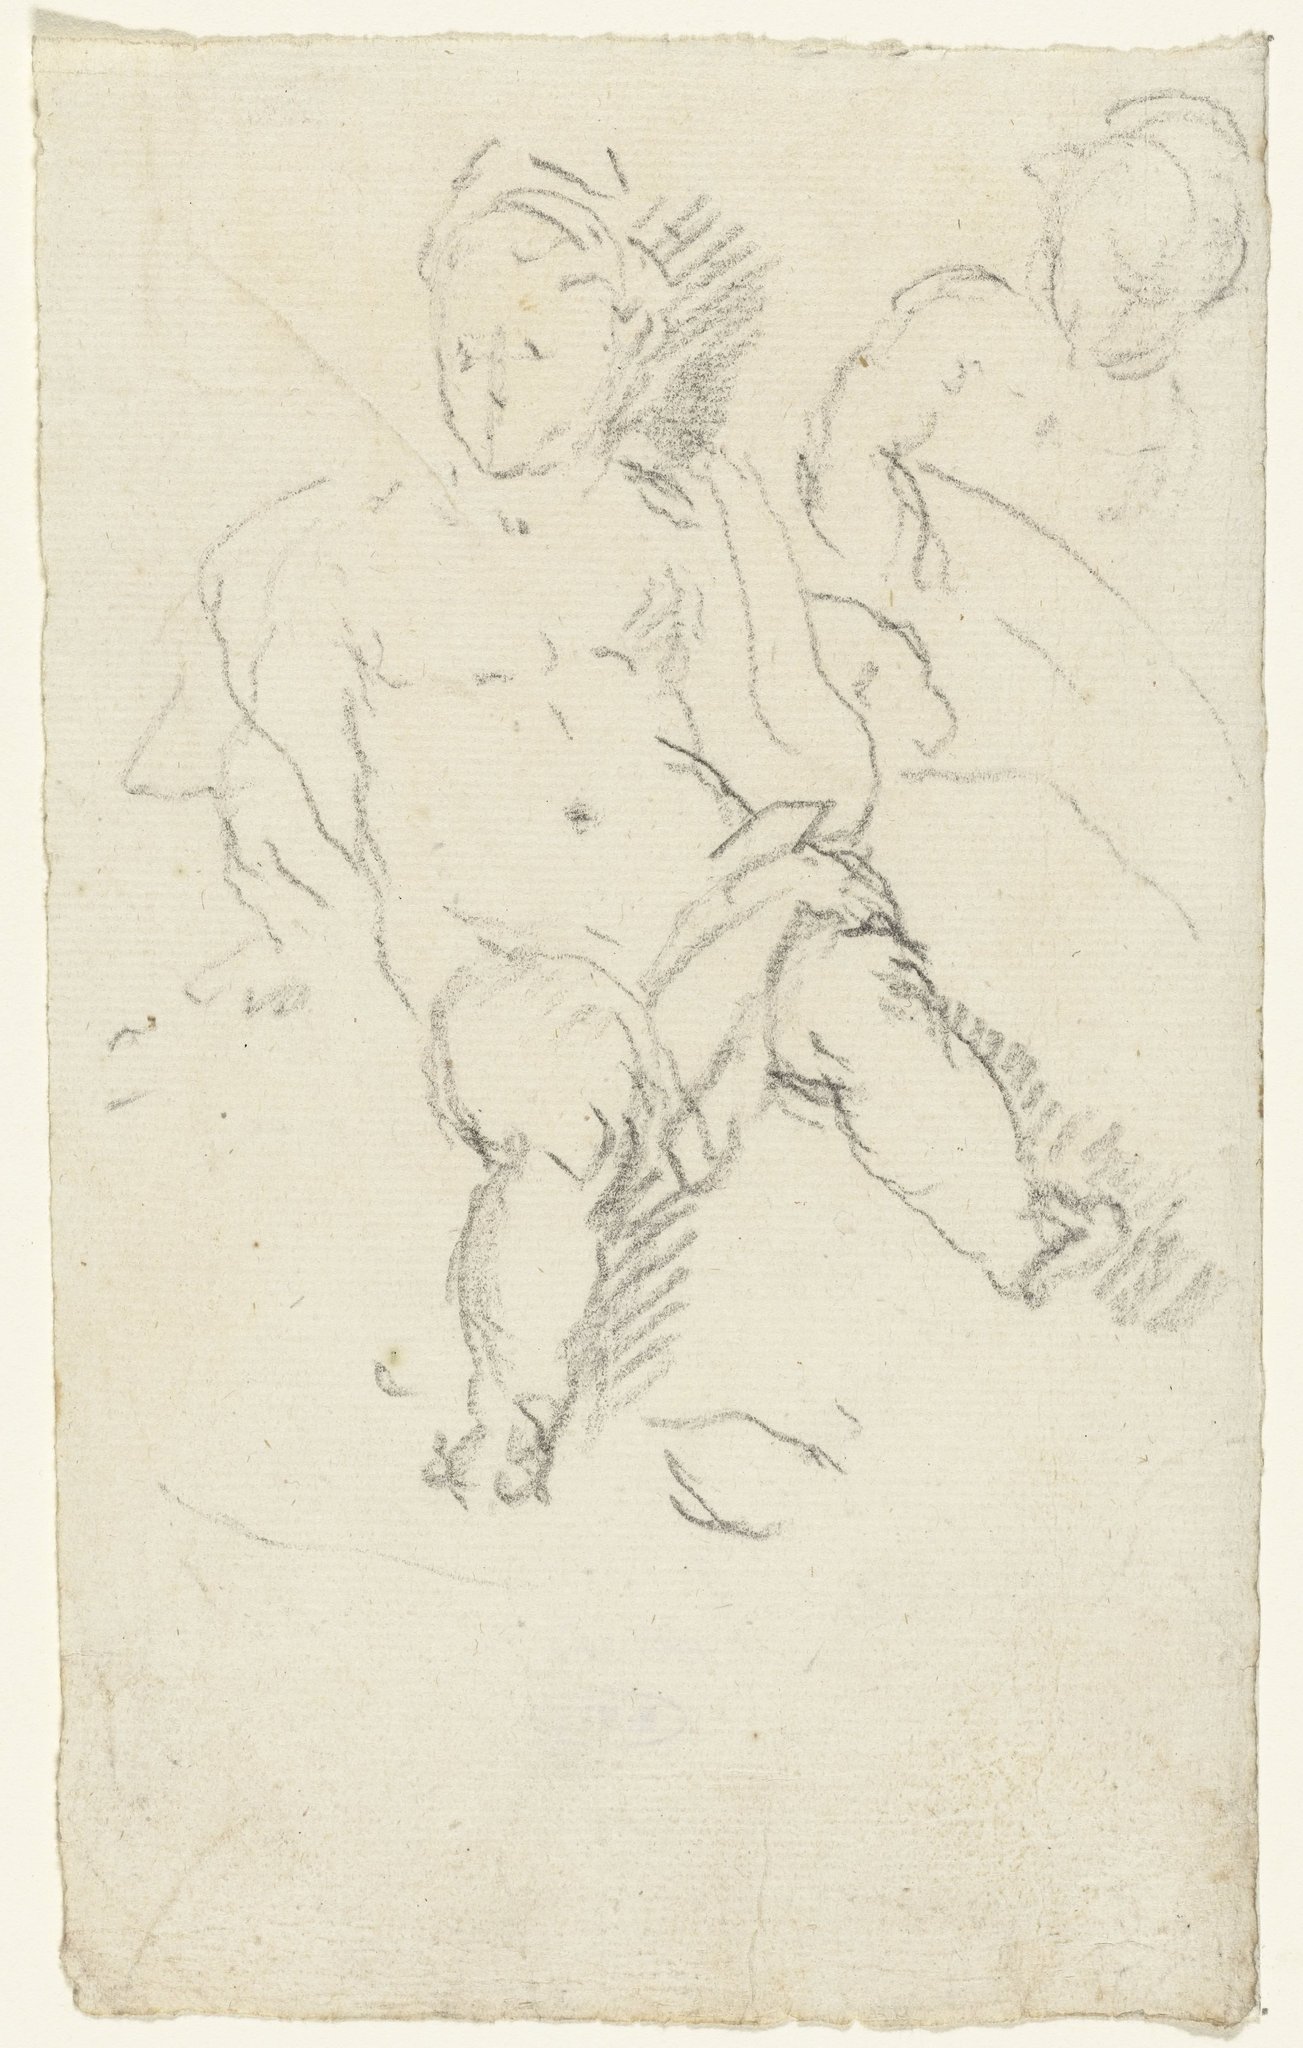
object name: drawing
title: Twee putti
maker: dionys van nijmegen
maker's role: draughtsman, painter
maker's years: 1705-1798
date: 1715-1798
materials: chalk, paper